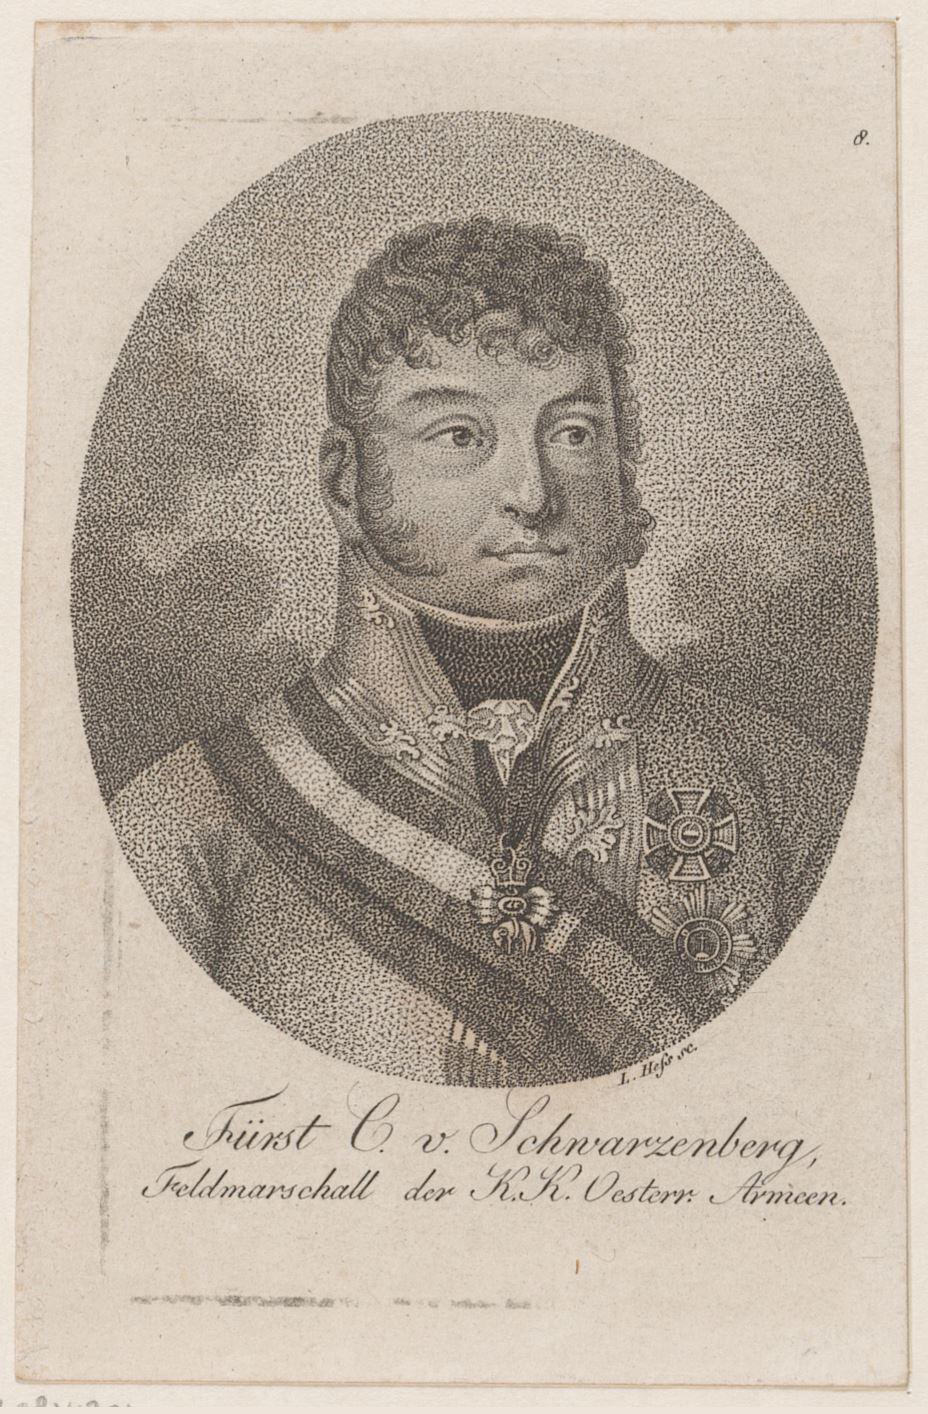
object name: print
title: Portret van Carl Philipp von Schwarzenberg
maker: ludwig hess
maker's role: painter, print maker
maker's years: 1760-1800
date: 1800-1899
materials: paper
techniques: engraving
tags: vienna, historical persons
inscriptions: collector's mark: Lugt 2228